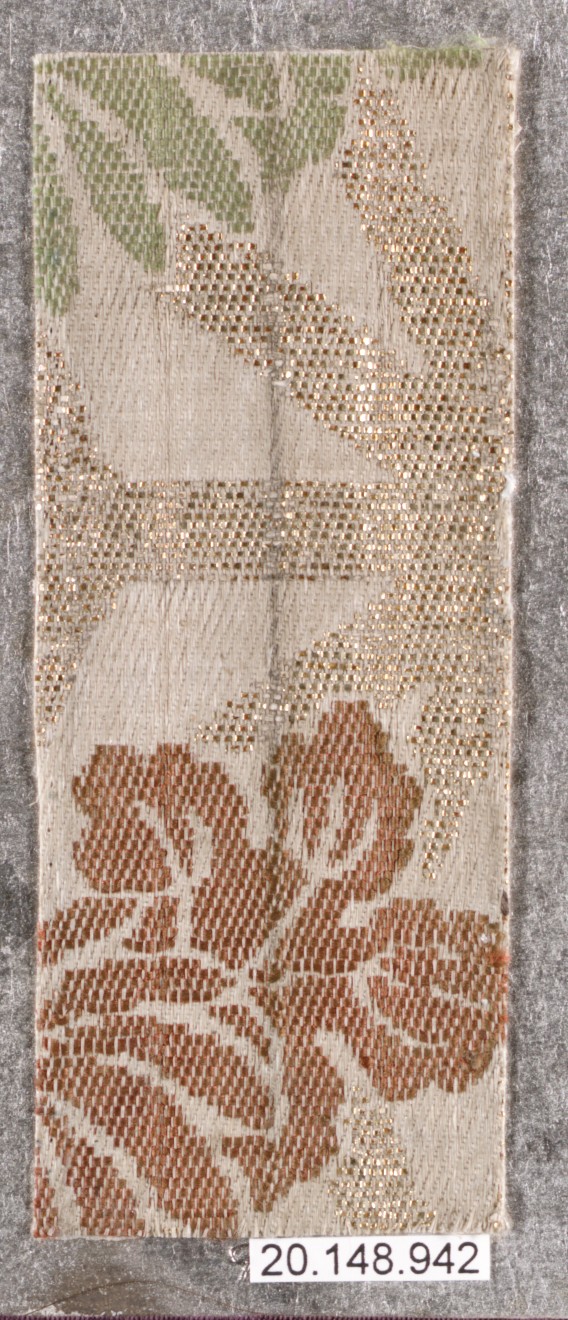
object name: piece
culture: japanese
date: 1601-1700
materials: silk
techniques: compound weave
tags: leaves